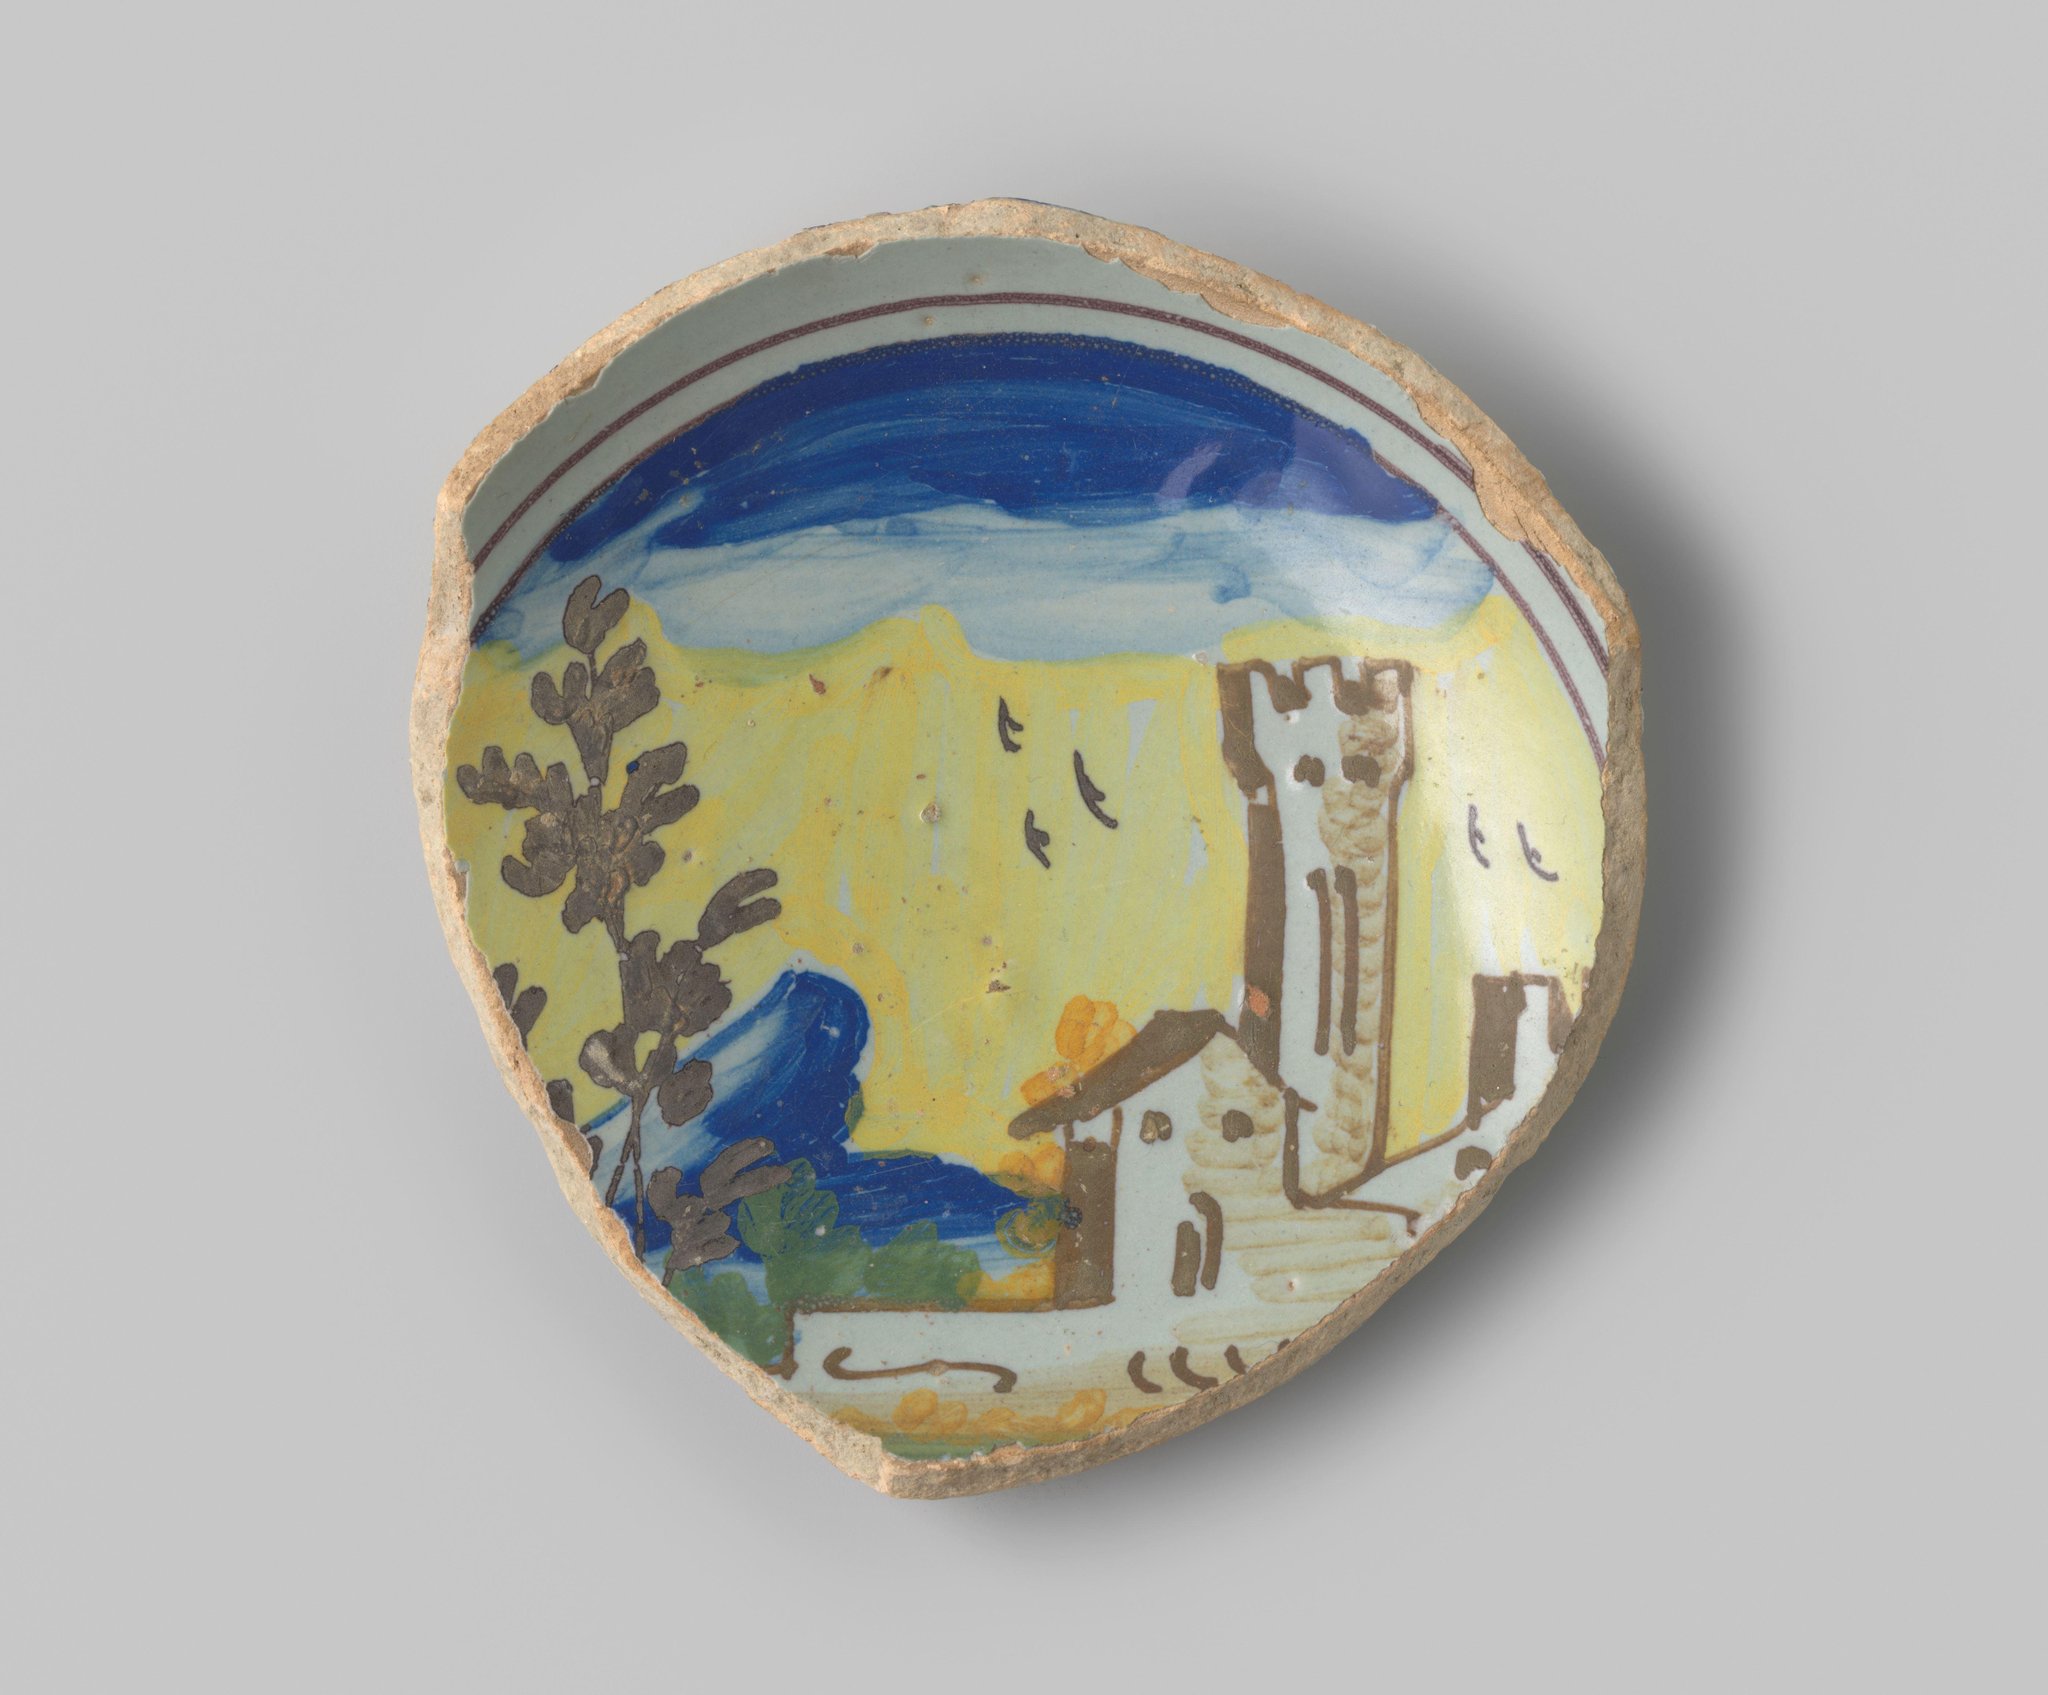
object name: sherd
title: Fragment (voetring) van een schotel met witbakkende scherf, met aan de voor- en achterzijde grijsblauw glazuur, waarop in blauw, bruin, geel oranje en groen aan de voorzijde een landschap met bebouwing is geschilderd, en aan de achterzijde strepen met bladvormen.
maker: Anonymous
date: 1200-1899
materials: earthenware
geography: italy